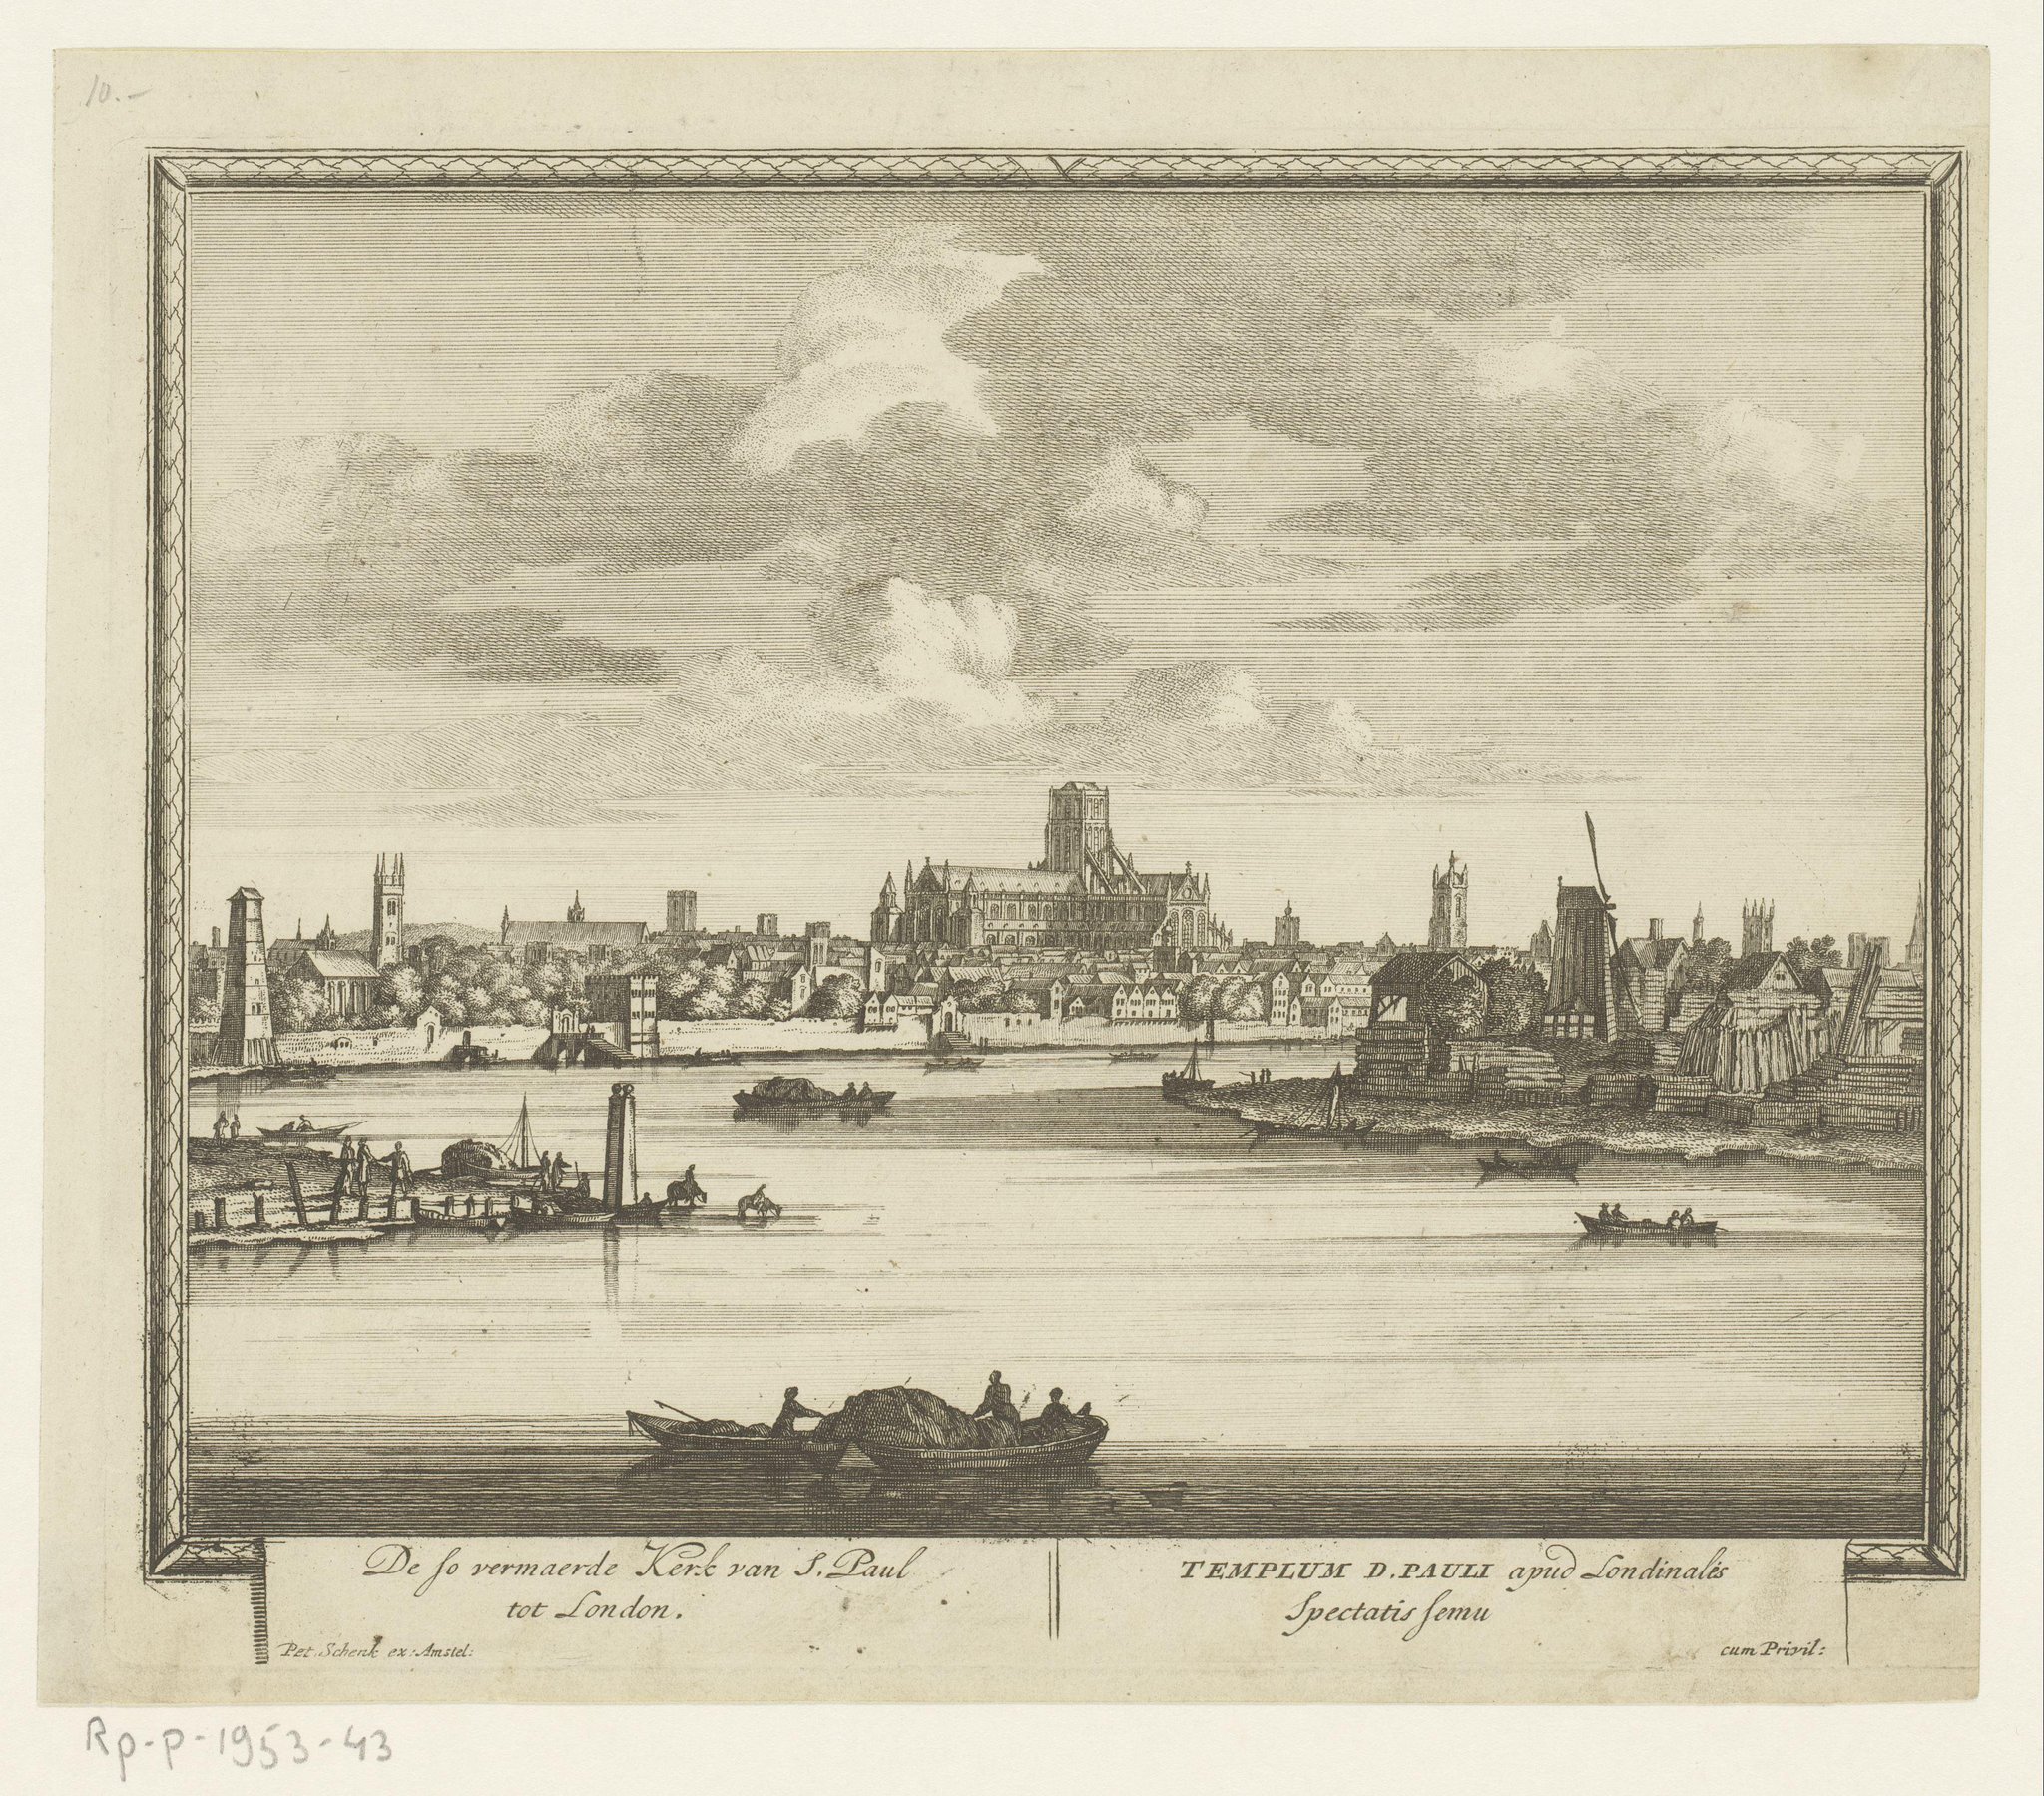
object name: print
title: Gezicht op St Paul's Cathedral, te London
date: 1702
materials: paper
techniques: engraving, etching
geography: amsterdam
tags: church (exterior), prospect of city, town panorama, silhouette of city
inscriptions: collector's mark: Lugt 2228